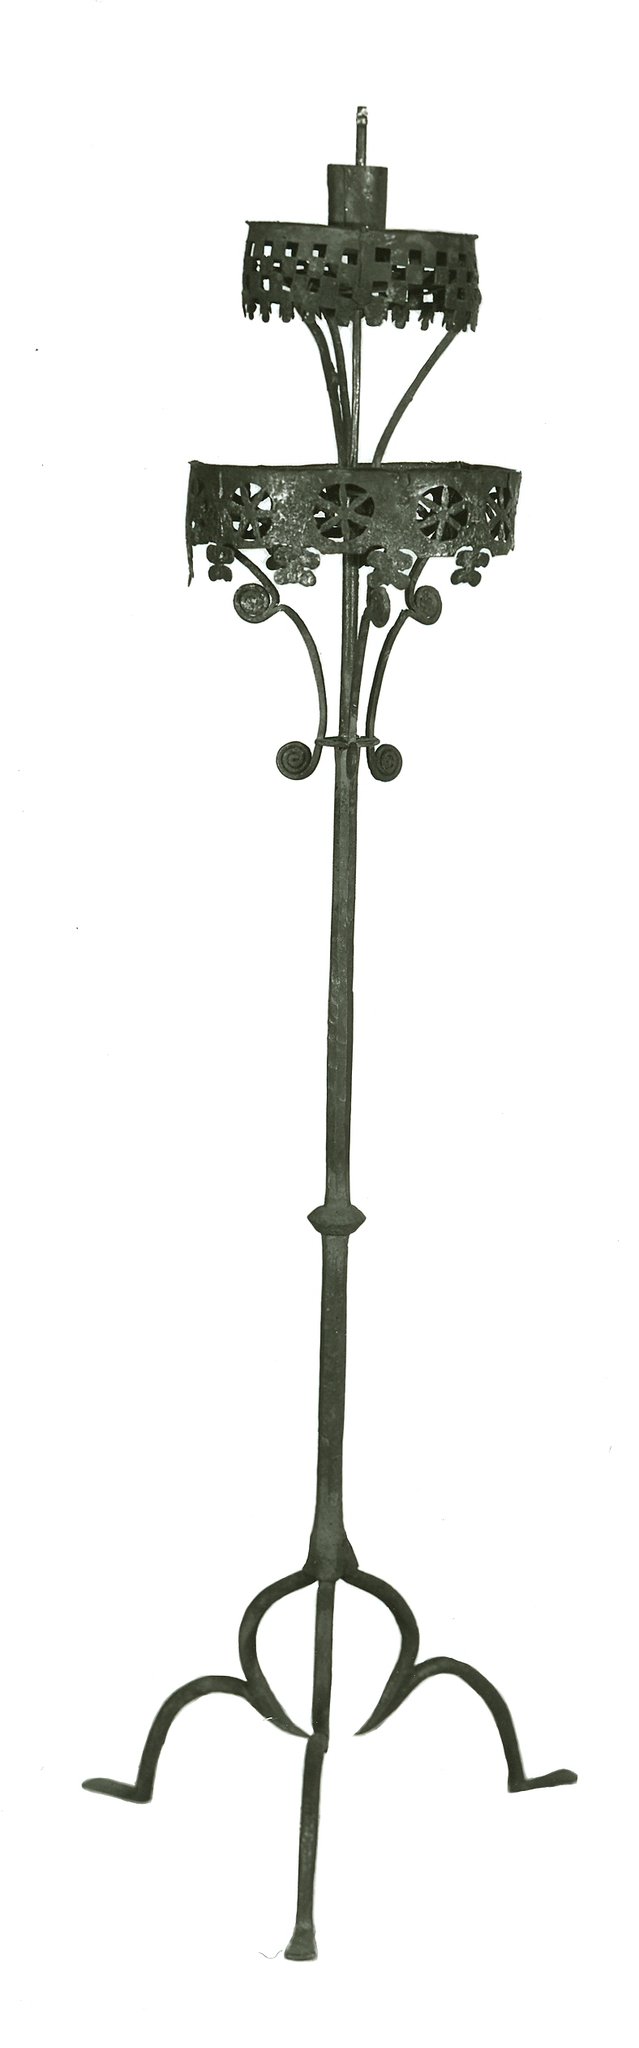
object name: candlestick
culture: french or spanish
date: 1401-1500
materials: iron